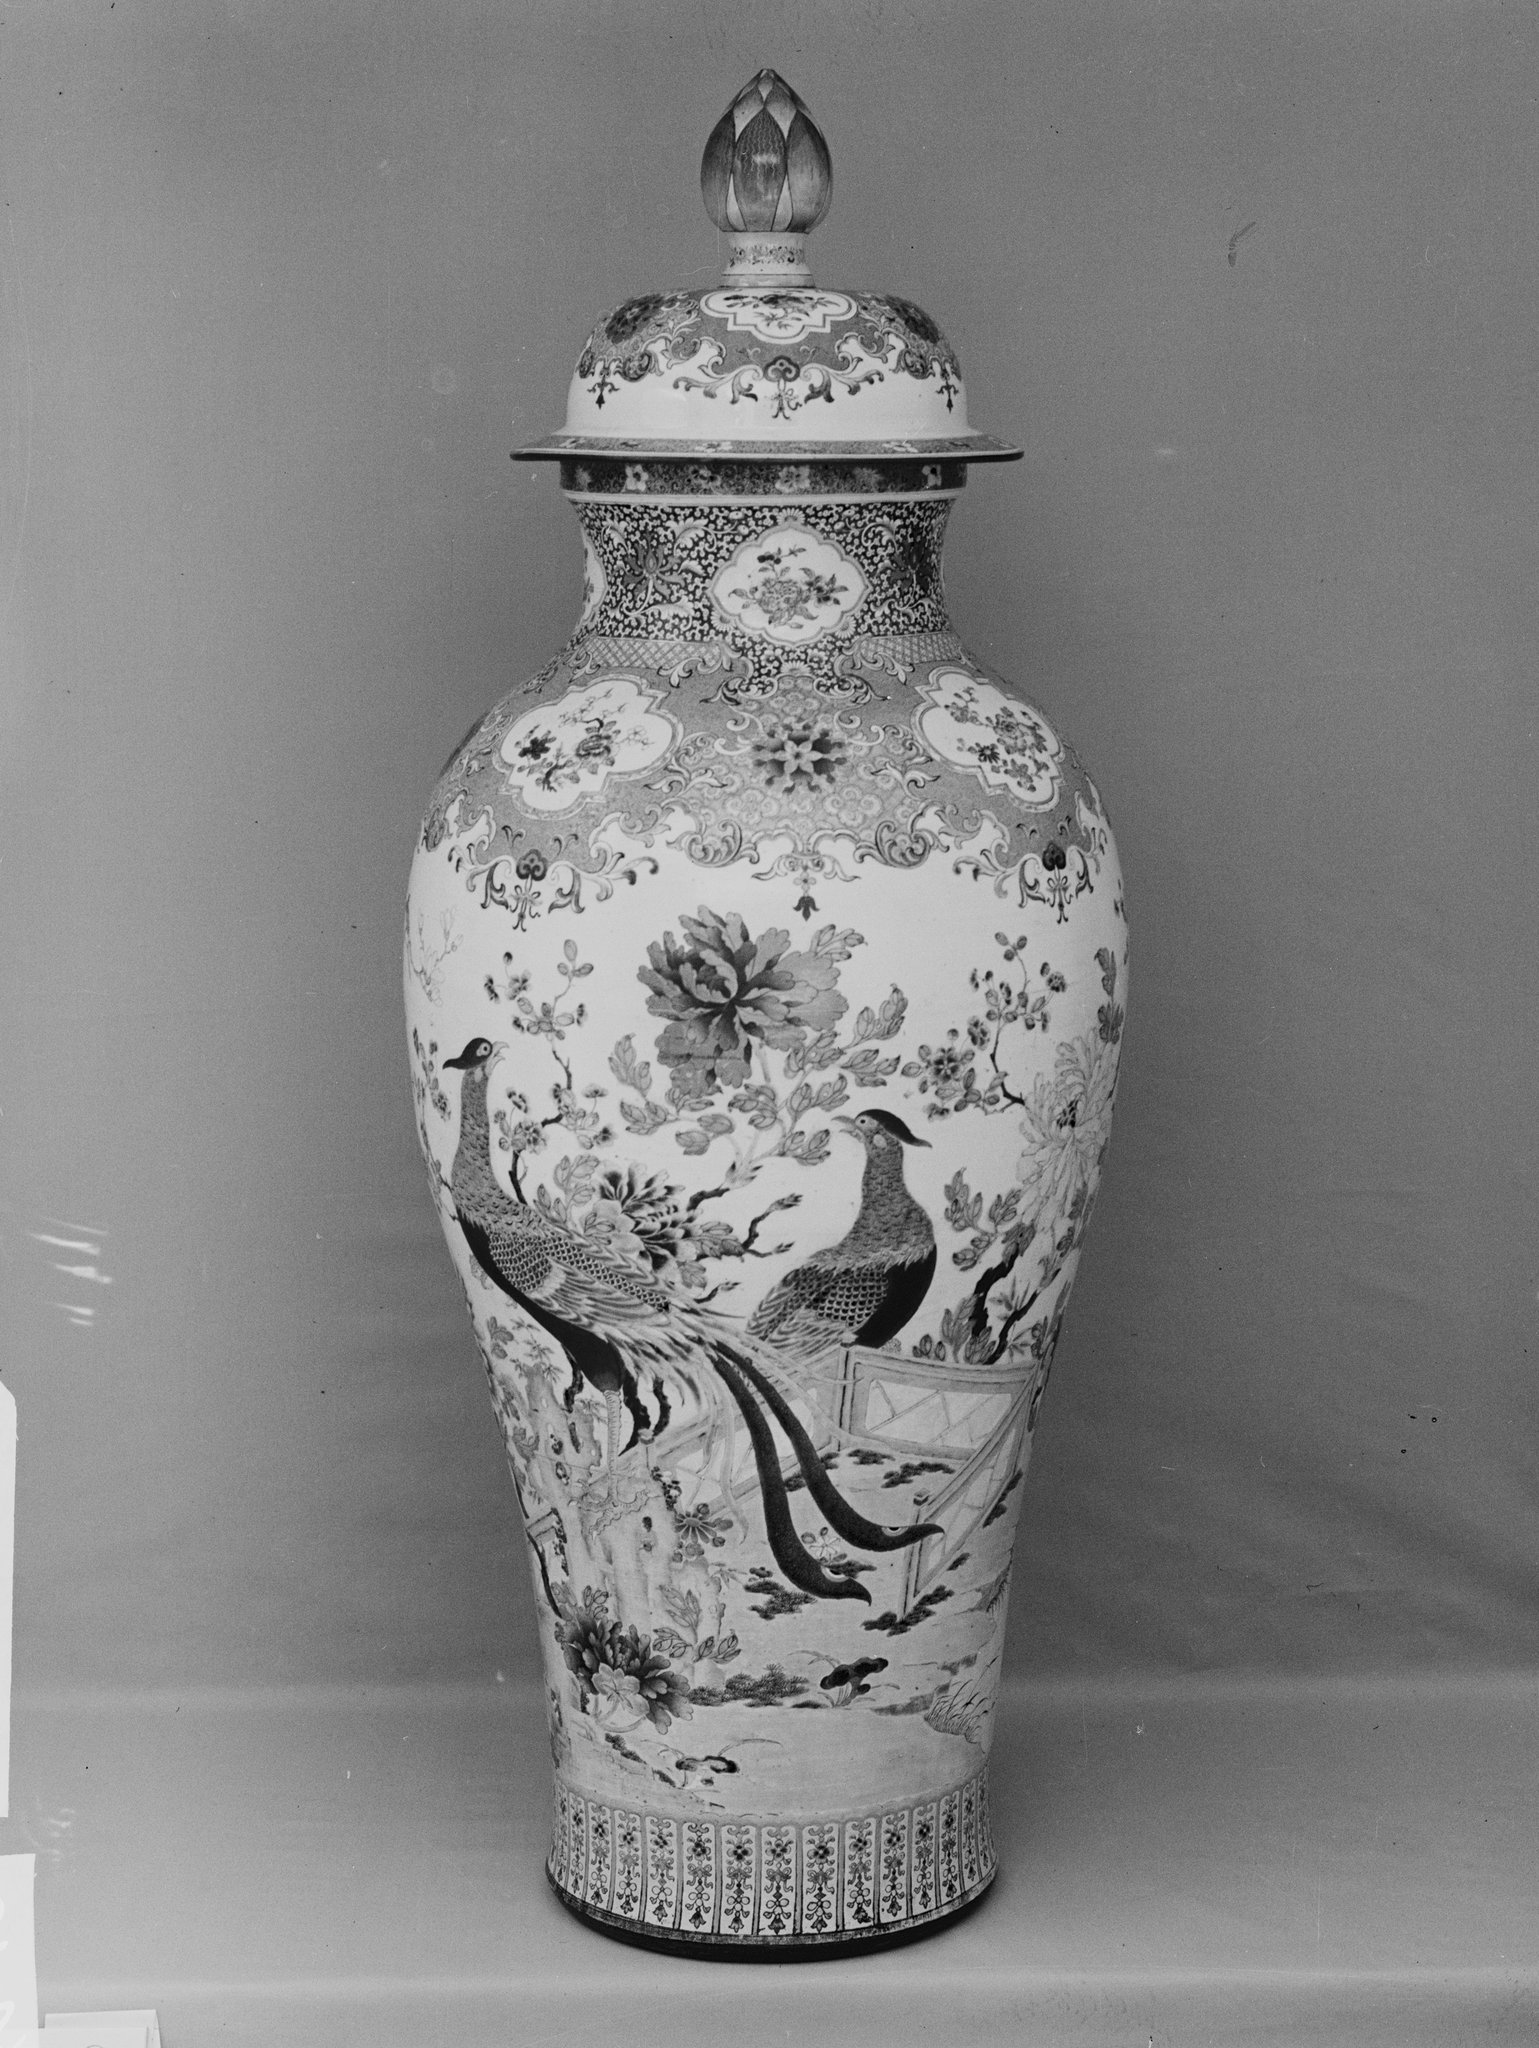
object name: vase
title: Large Vase with Cover and Design of Peacocks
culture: chinese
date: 1736-1795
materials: porcelain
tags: peacocks,flowers,leaves